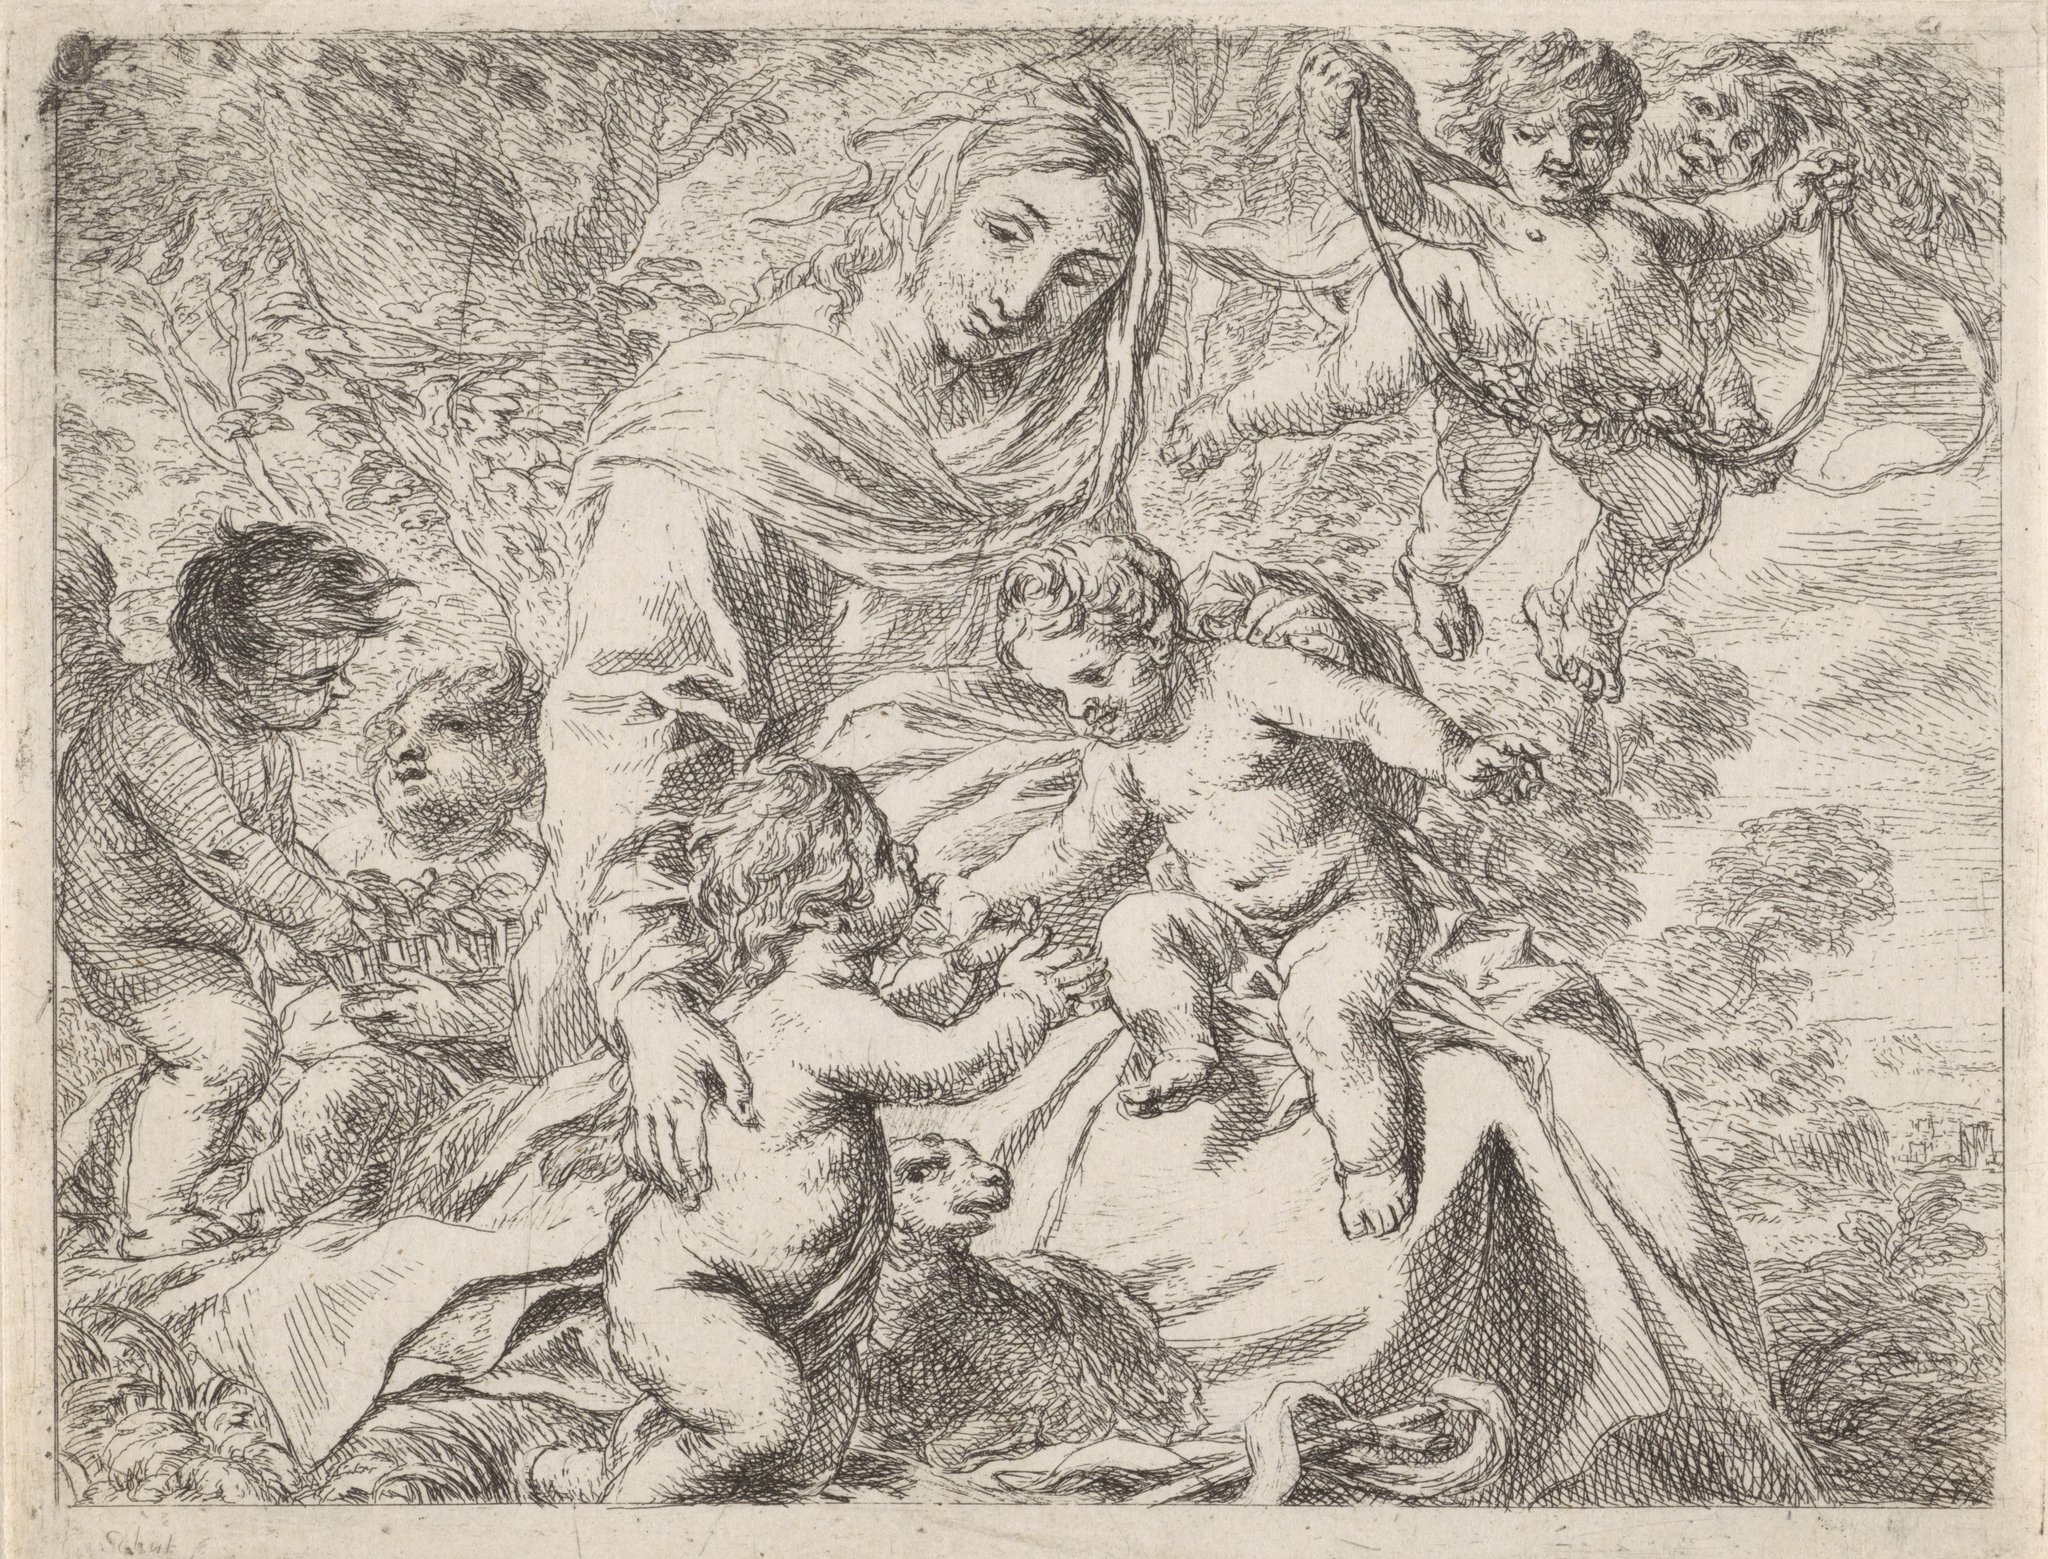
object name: print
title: Maria met kind en Johannes de Doper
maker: cornelis schut (i)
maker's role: draughtsman, print maker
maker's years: 1597-1655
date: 1618-1655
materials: paper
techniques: etching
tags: mary and the christ-child with john the baptist (as child)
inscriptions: collector's mark: Lugt 2228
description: In een landschap zit Maria met op haar schoot het Christuskind. Haar andere hand rust op de rug van de jonge Johannes de Doper, die zijn handen uitstrekt naar het lachende Christuskind. Aan weerszijden twee putti.